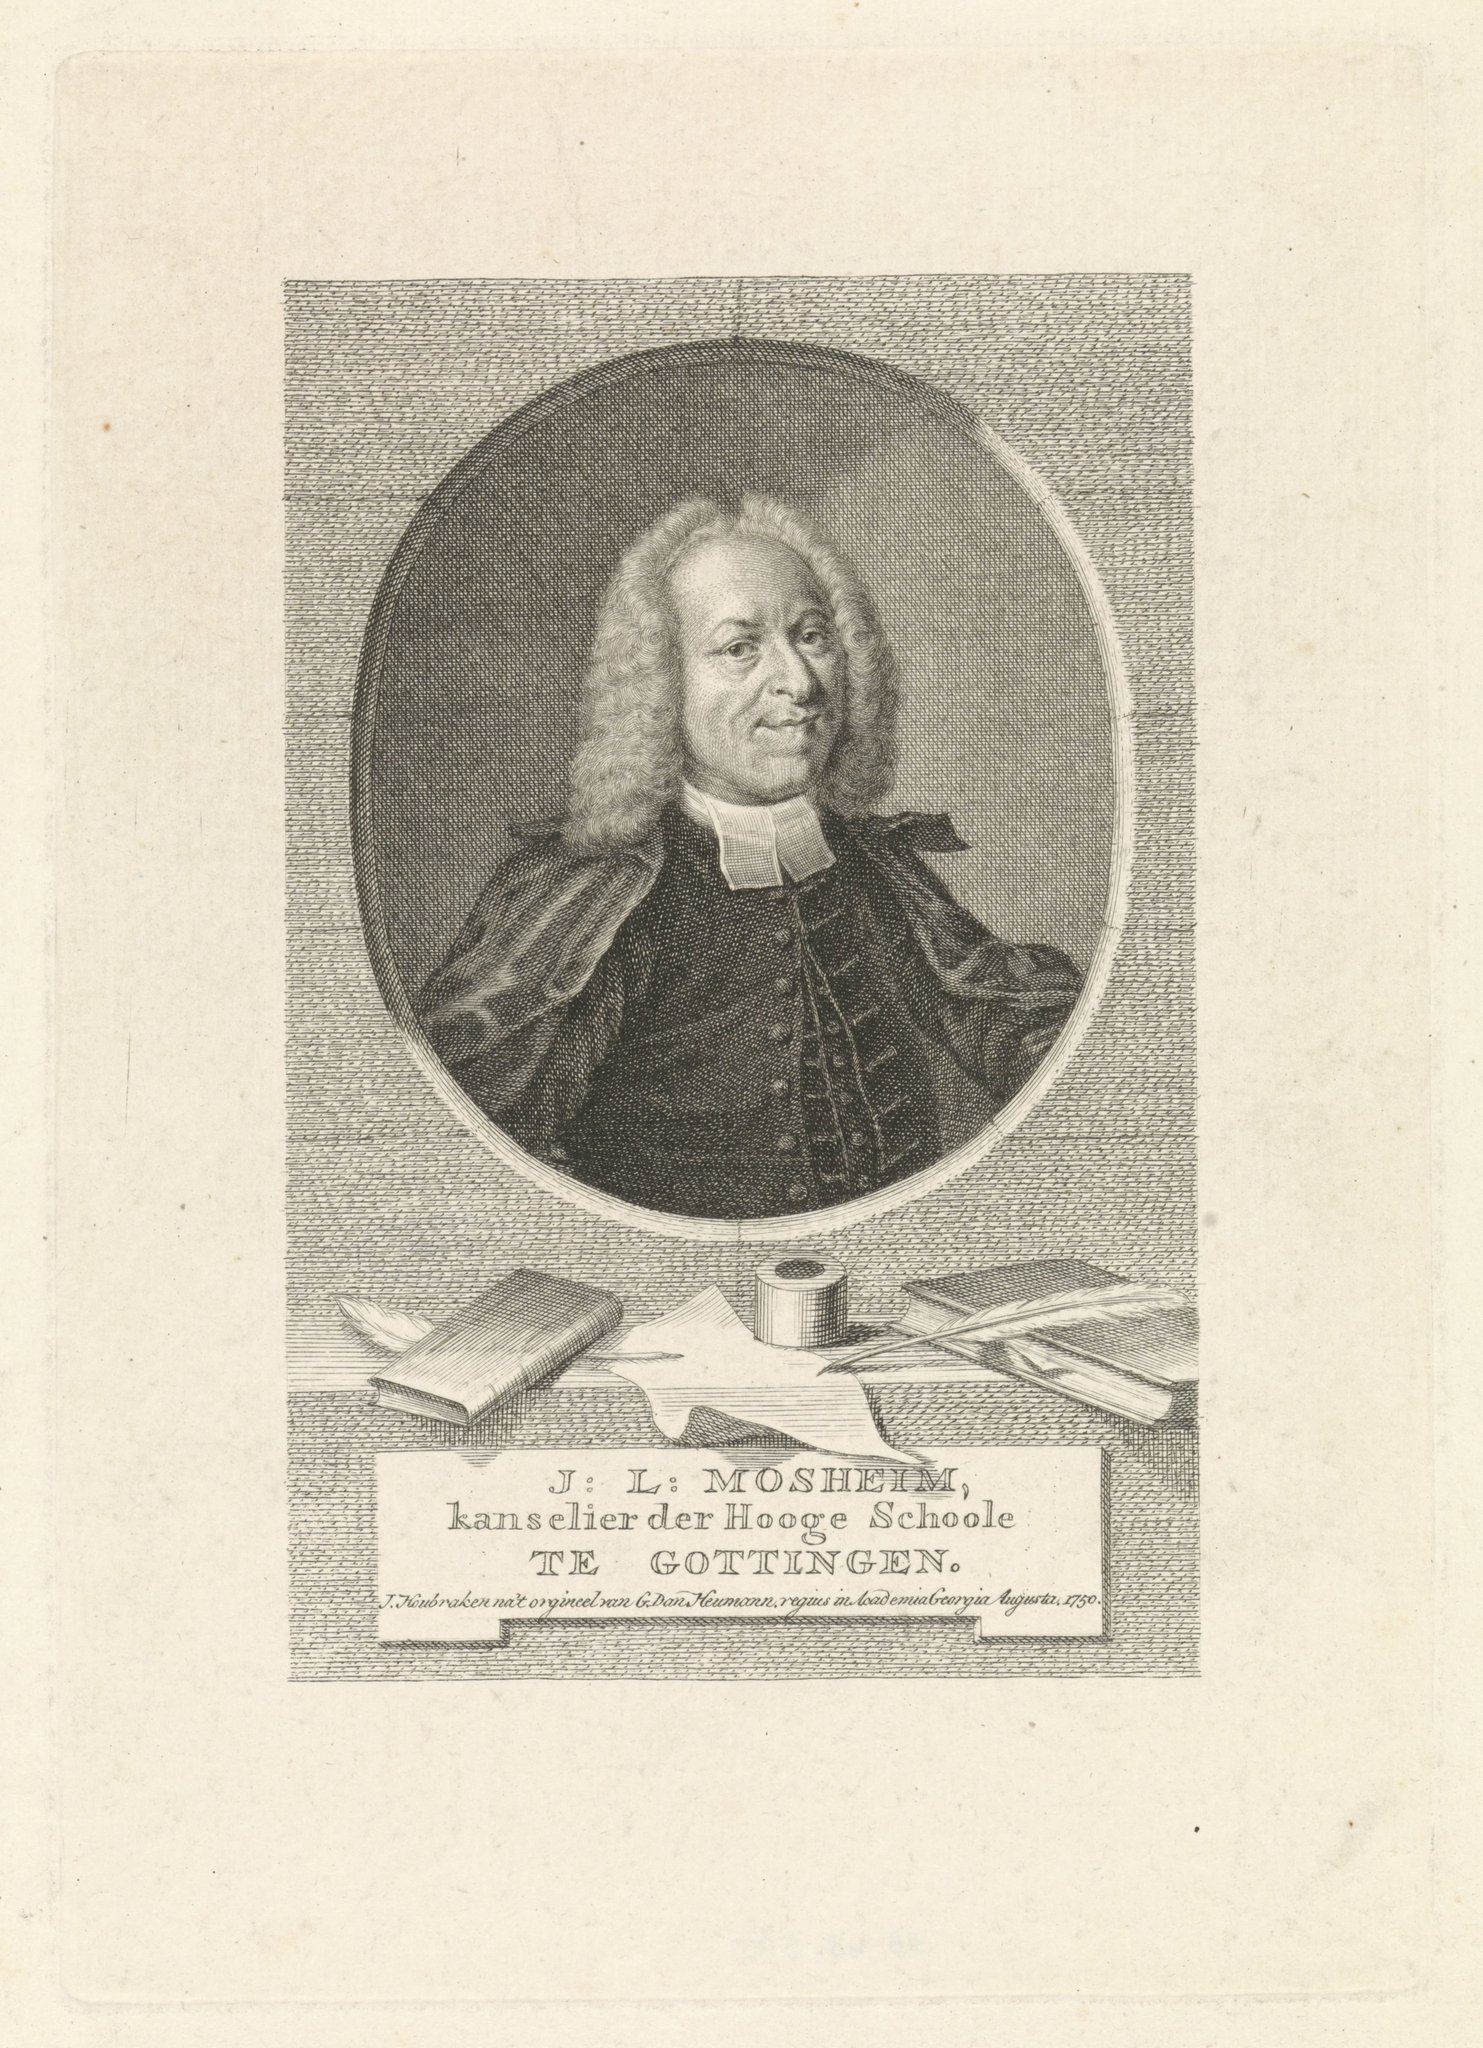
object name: print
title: J: L: Mosheim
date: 1750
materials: paper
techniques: engraving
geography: amsterdam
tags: quill, ink-well, paper (writing material)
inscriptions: collector's mark: Lugt 2228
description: Buste naar rechts van Johann Lorenz von Mosheim in een architectonisch ovaal. Onder het ovaal een richel waarop boeken, een vel papier, schrijfveren en een inktpot. Daaronder zijn naam en gegevens in drie regels in het Nederlands.